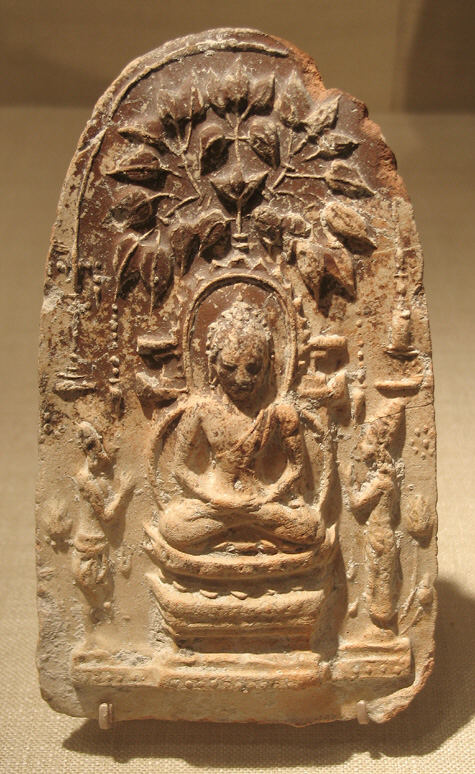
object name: votive plaque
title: Buddha Seated under the Bodhi Tree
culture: thai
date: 601-900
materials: lacquer, terracotta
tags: trees,buddhism,buddha